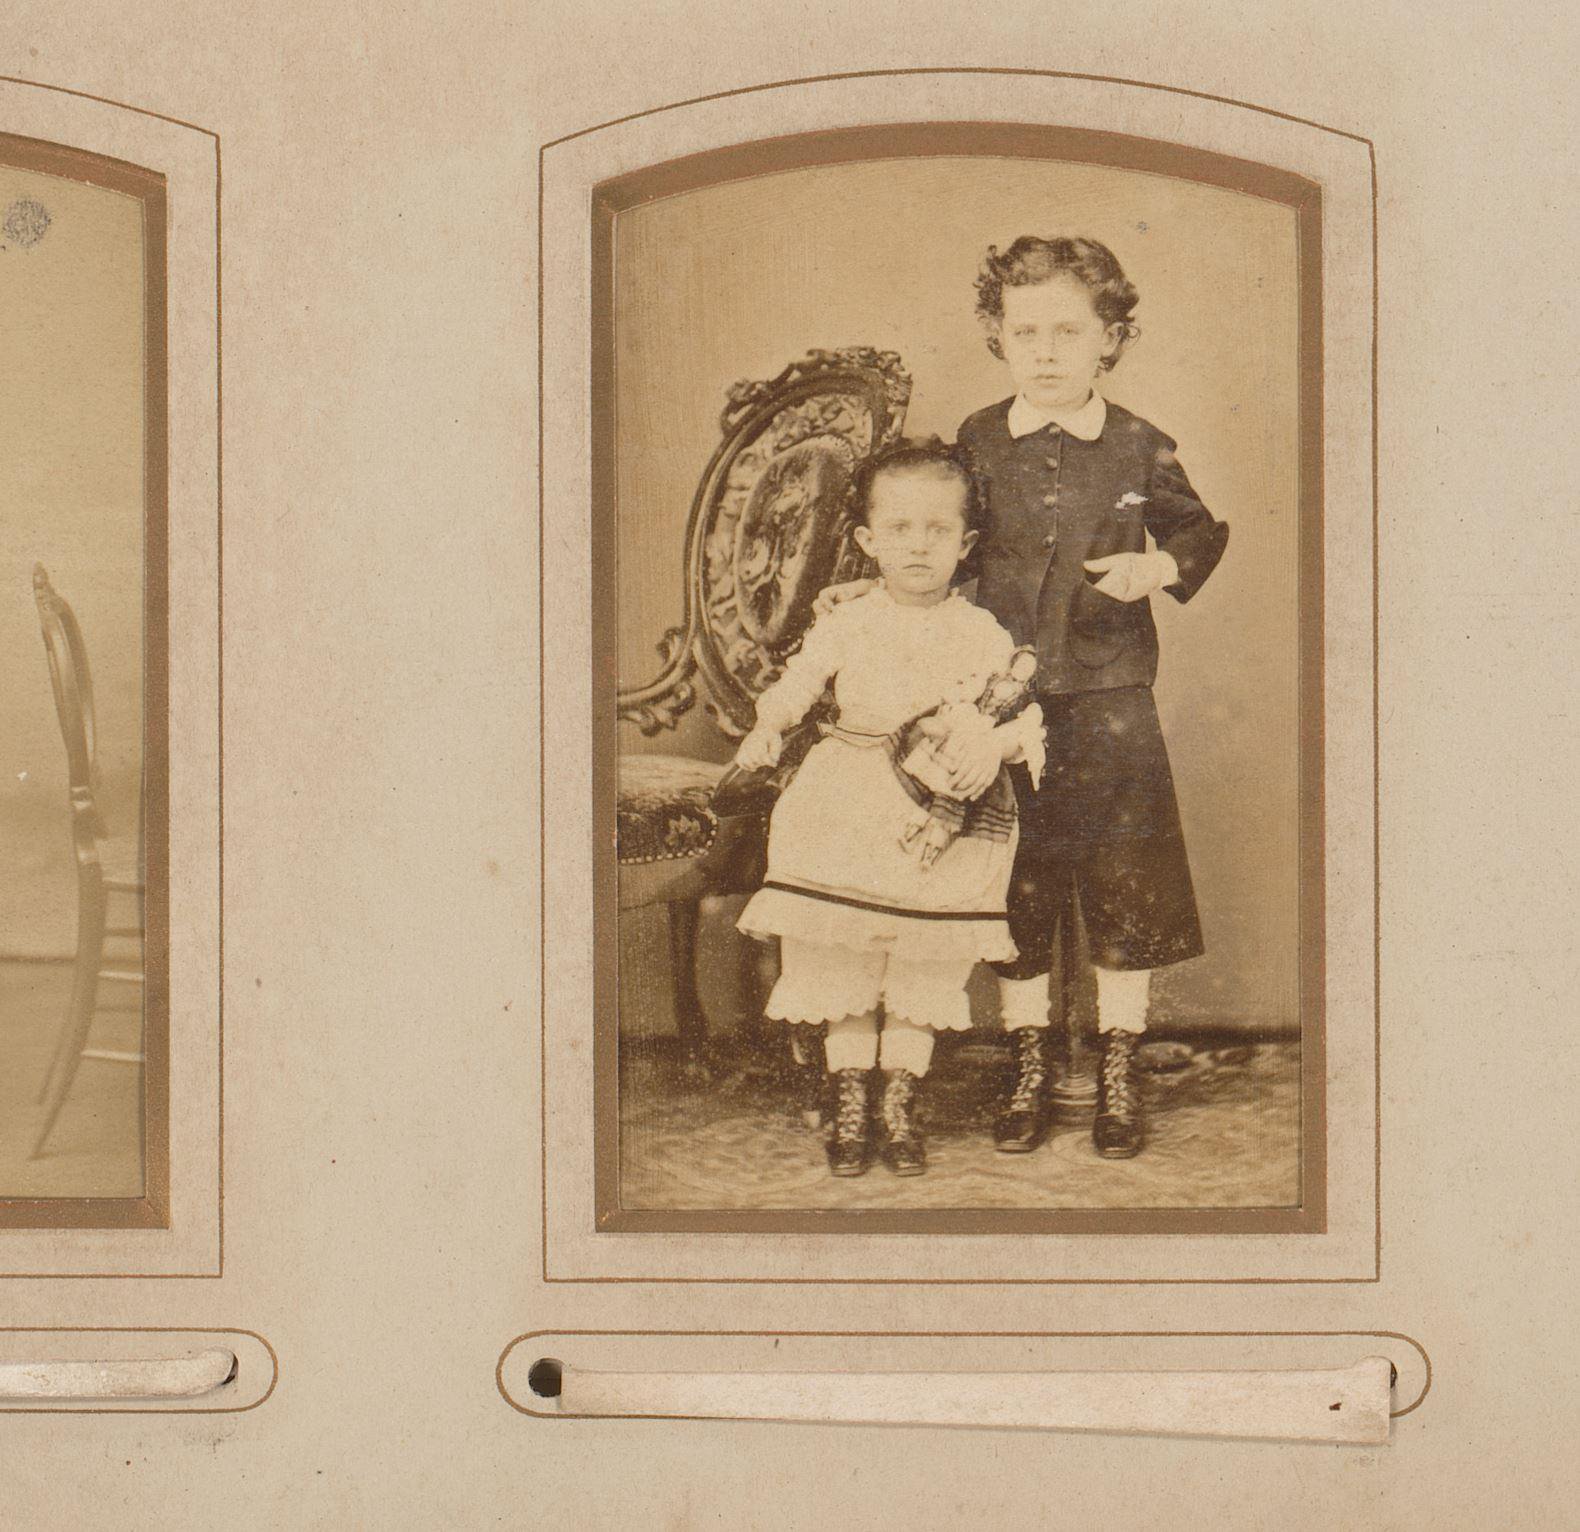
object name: photograph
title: Portret van twee kinderen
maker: j.b. jasper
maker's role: fotograaf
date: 1870-1899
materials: cardboard, celluloid, photographic support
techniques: albumen print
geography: surabaya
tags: historical persons - bb - woman, historical persons, child (+ two persons)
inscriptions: inscription: ‘J.B. JASPER/ Photograaf/ SOERABAYA.’